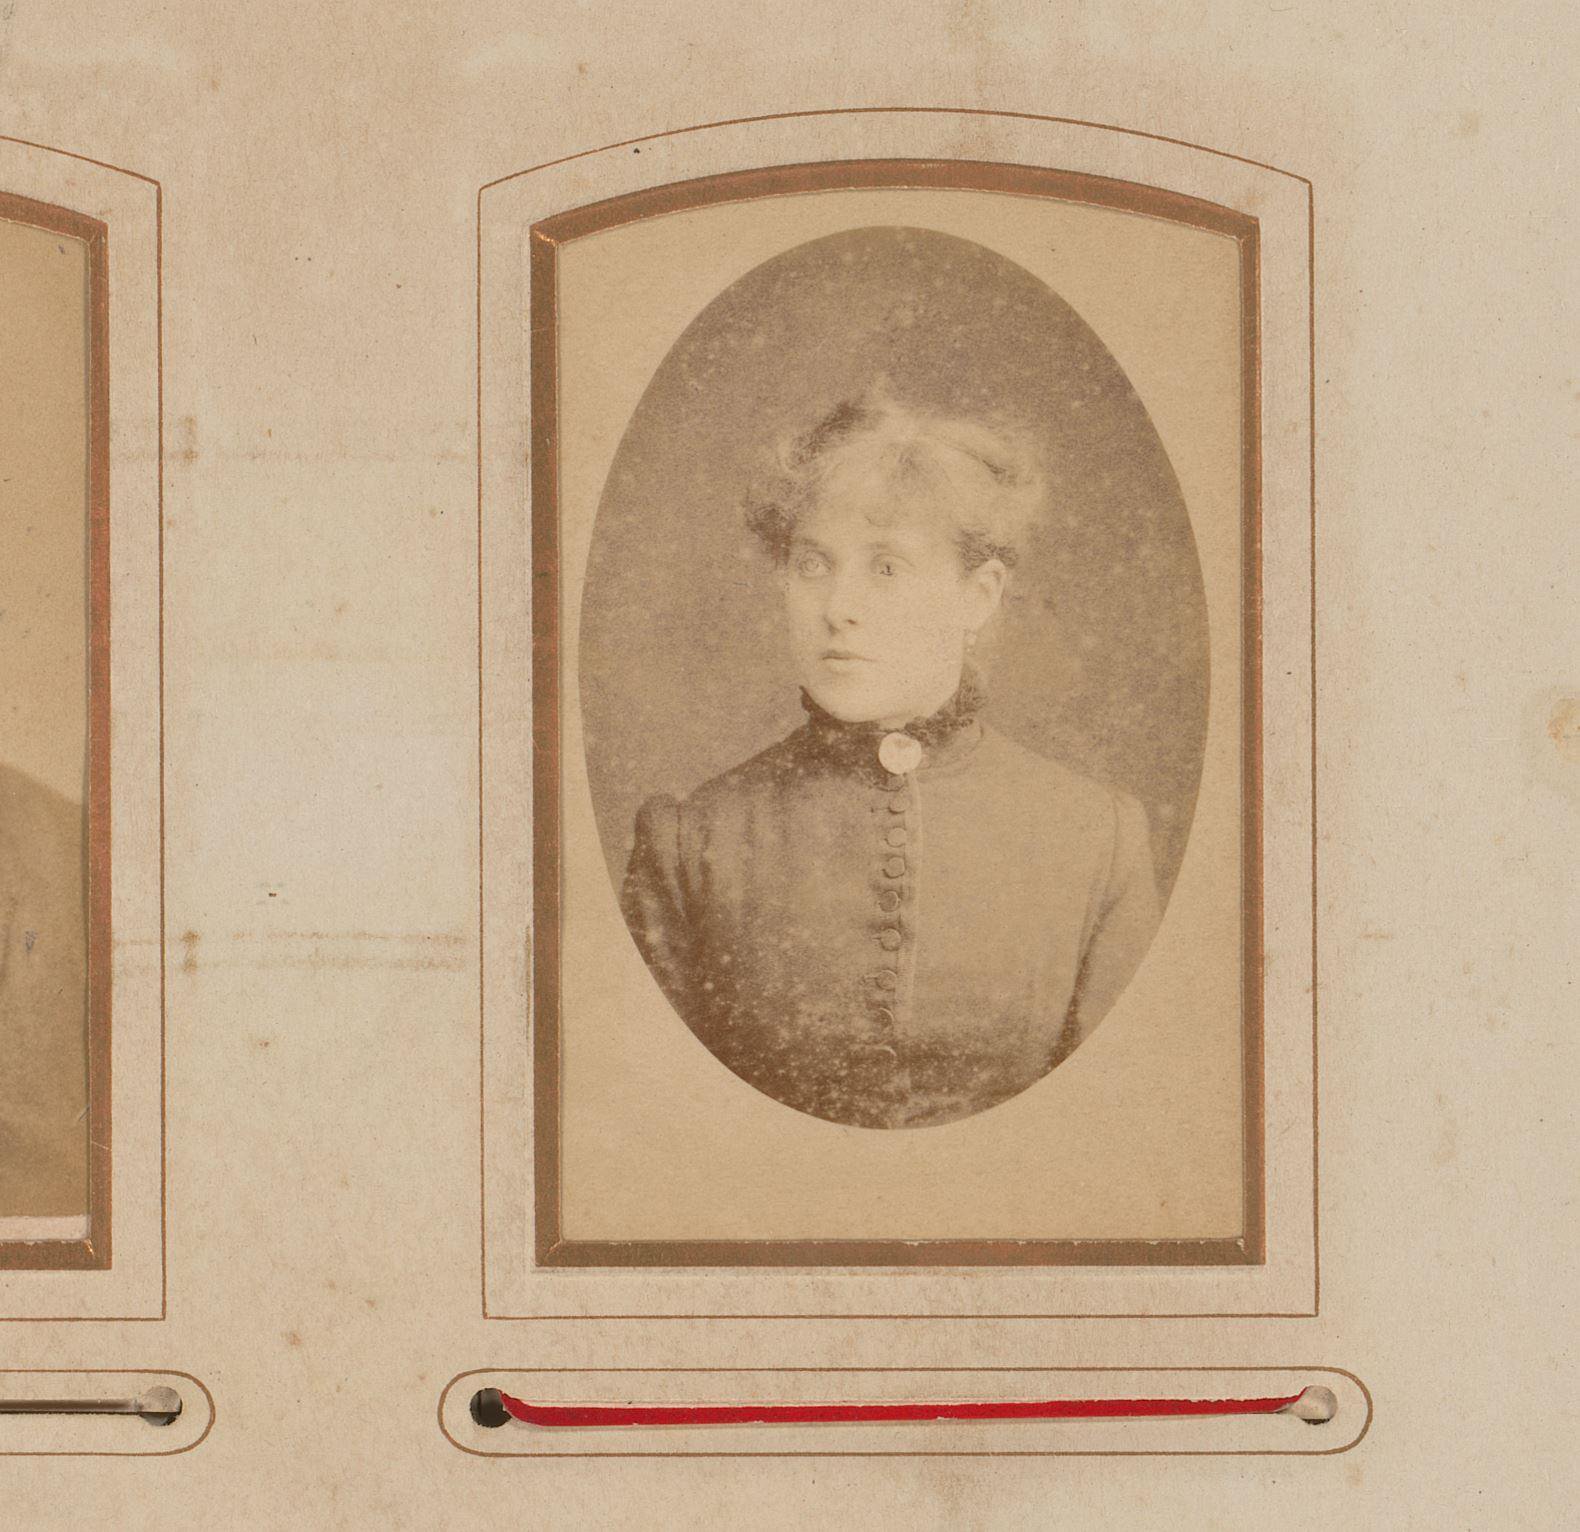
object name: carte de visite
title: Portret van een vrouw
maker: egide-françois billotte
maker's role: fotograaf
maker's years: 1828-1911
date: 1860-1900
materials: cardboard, photographic support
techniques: albumen print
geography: brussels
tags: historical persons - bb - woman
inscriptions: inscription: ‘Photographie/ Artistique/ BRUXELLES/ Photographie au Charbon Inaltérable’